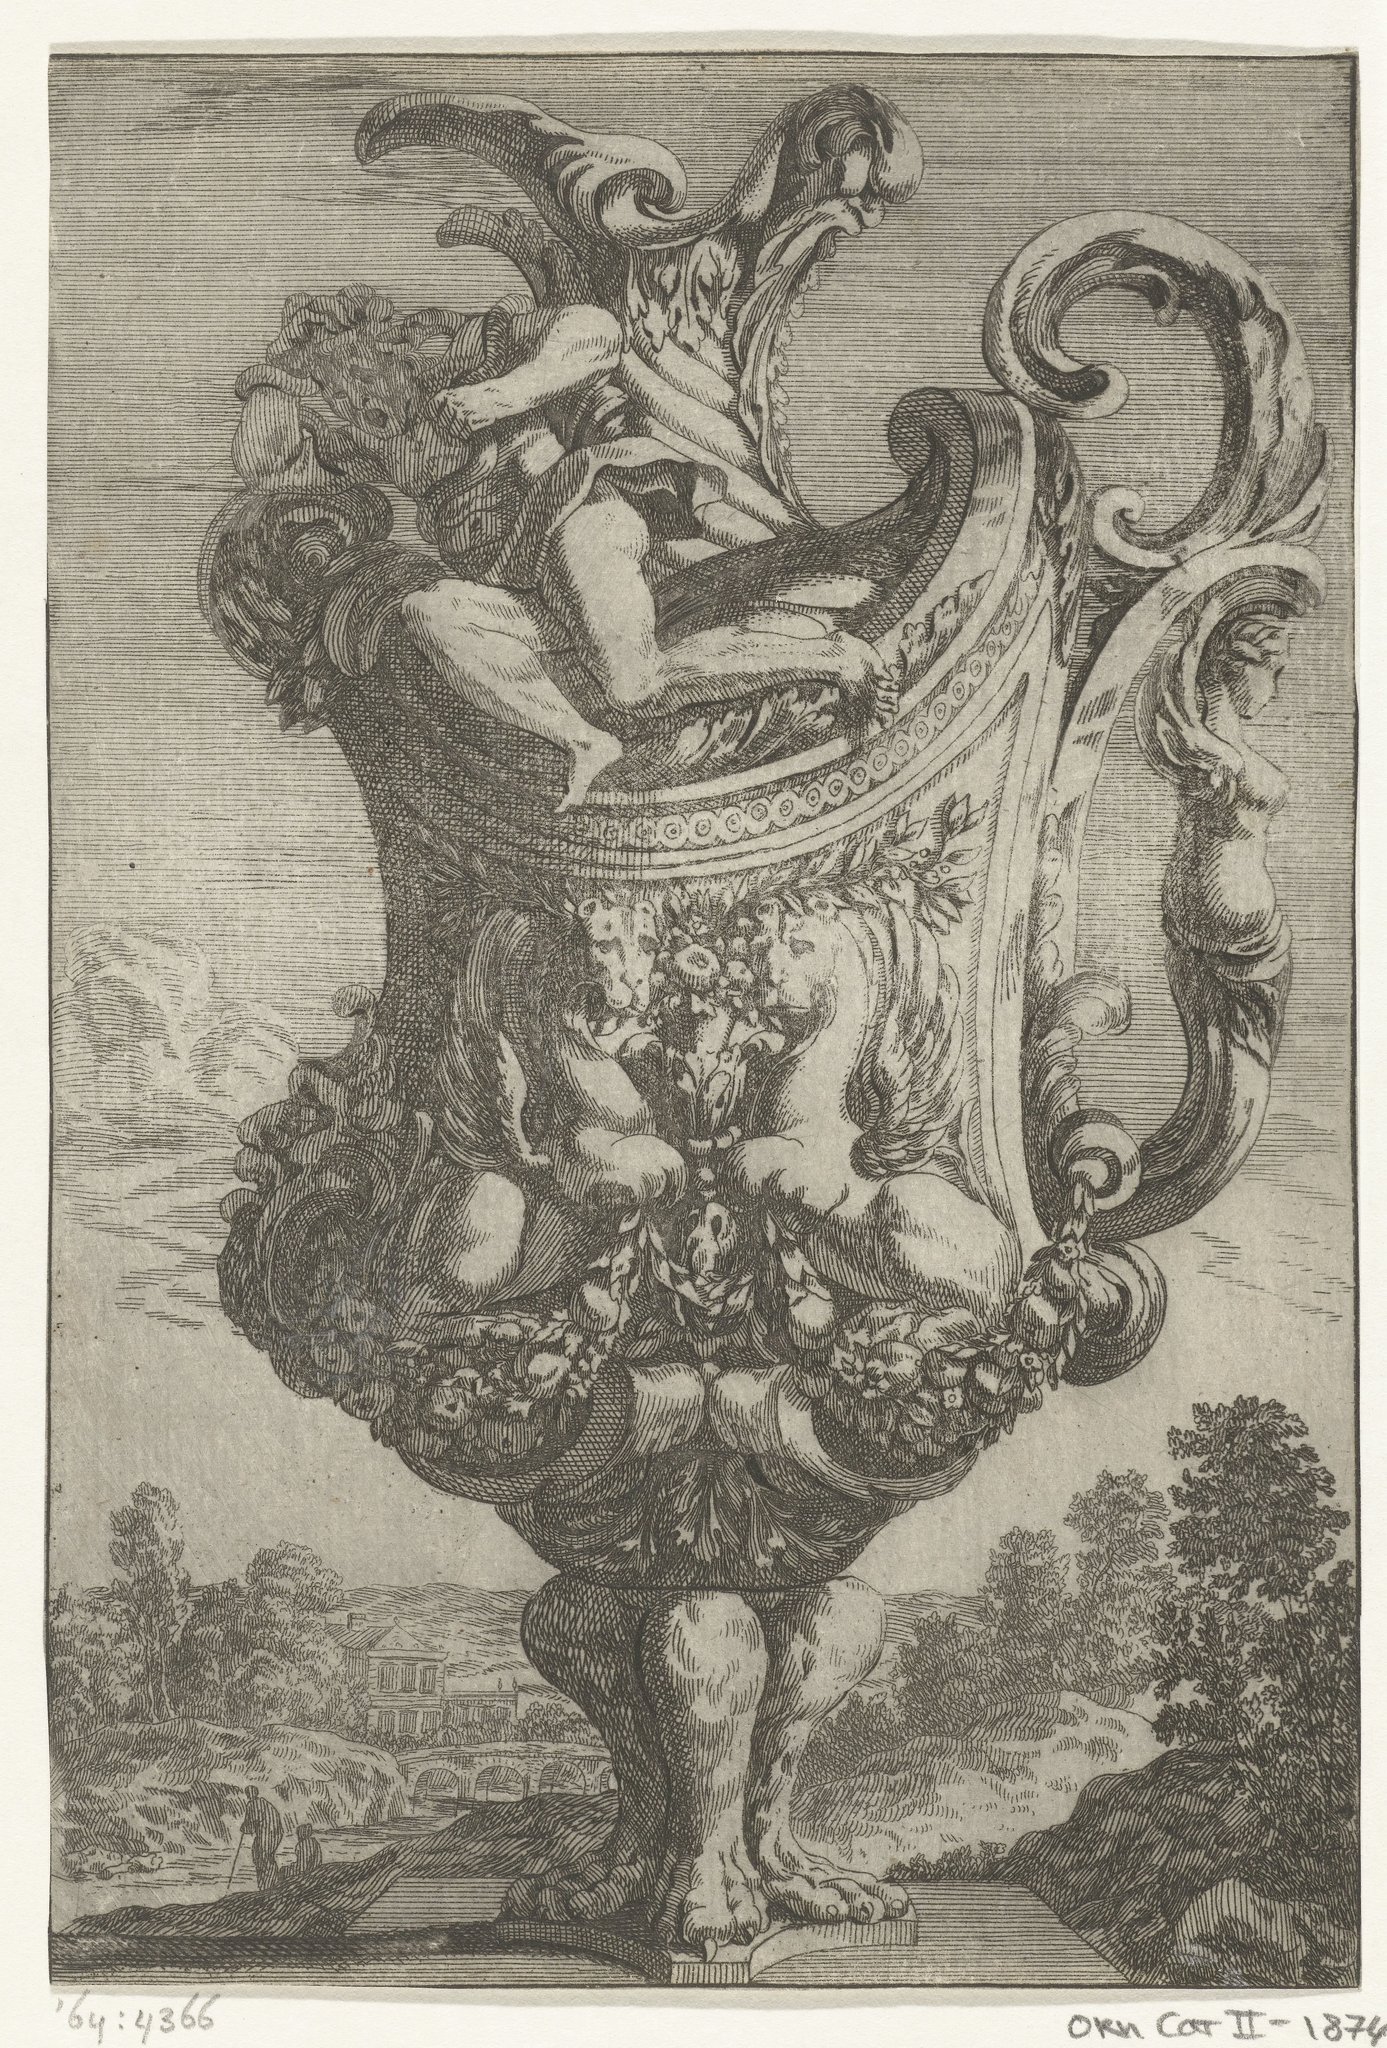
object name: print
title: Schenkkannen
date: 1628-1732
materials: paper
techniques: etching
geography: netherlands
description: Op de kan zit een man die gebeten wordt door een slang. Uit serie van 6 bladen.